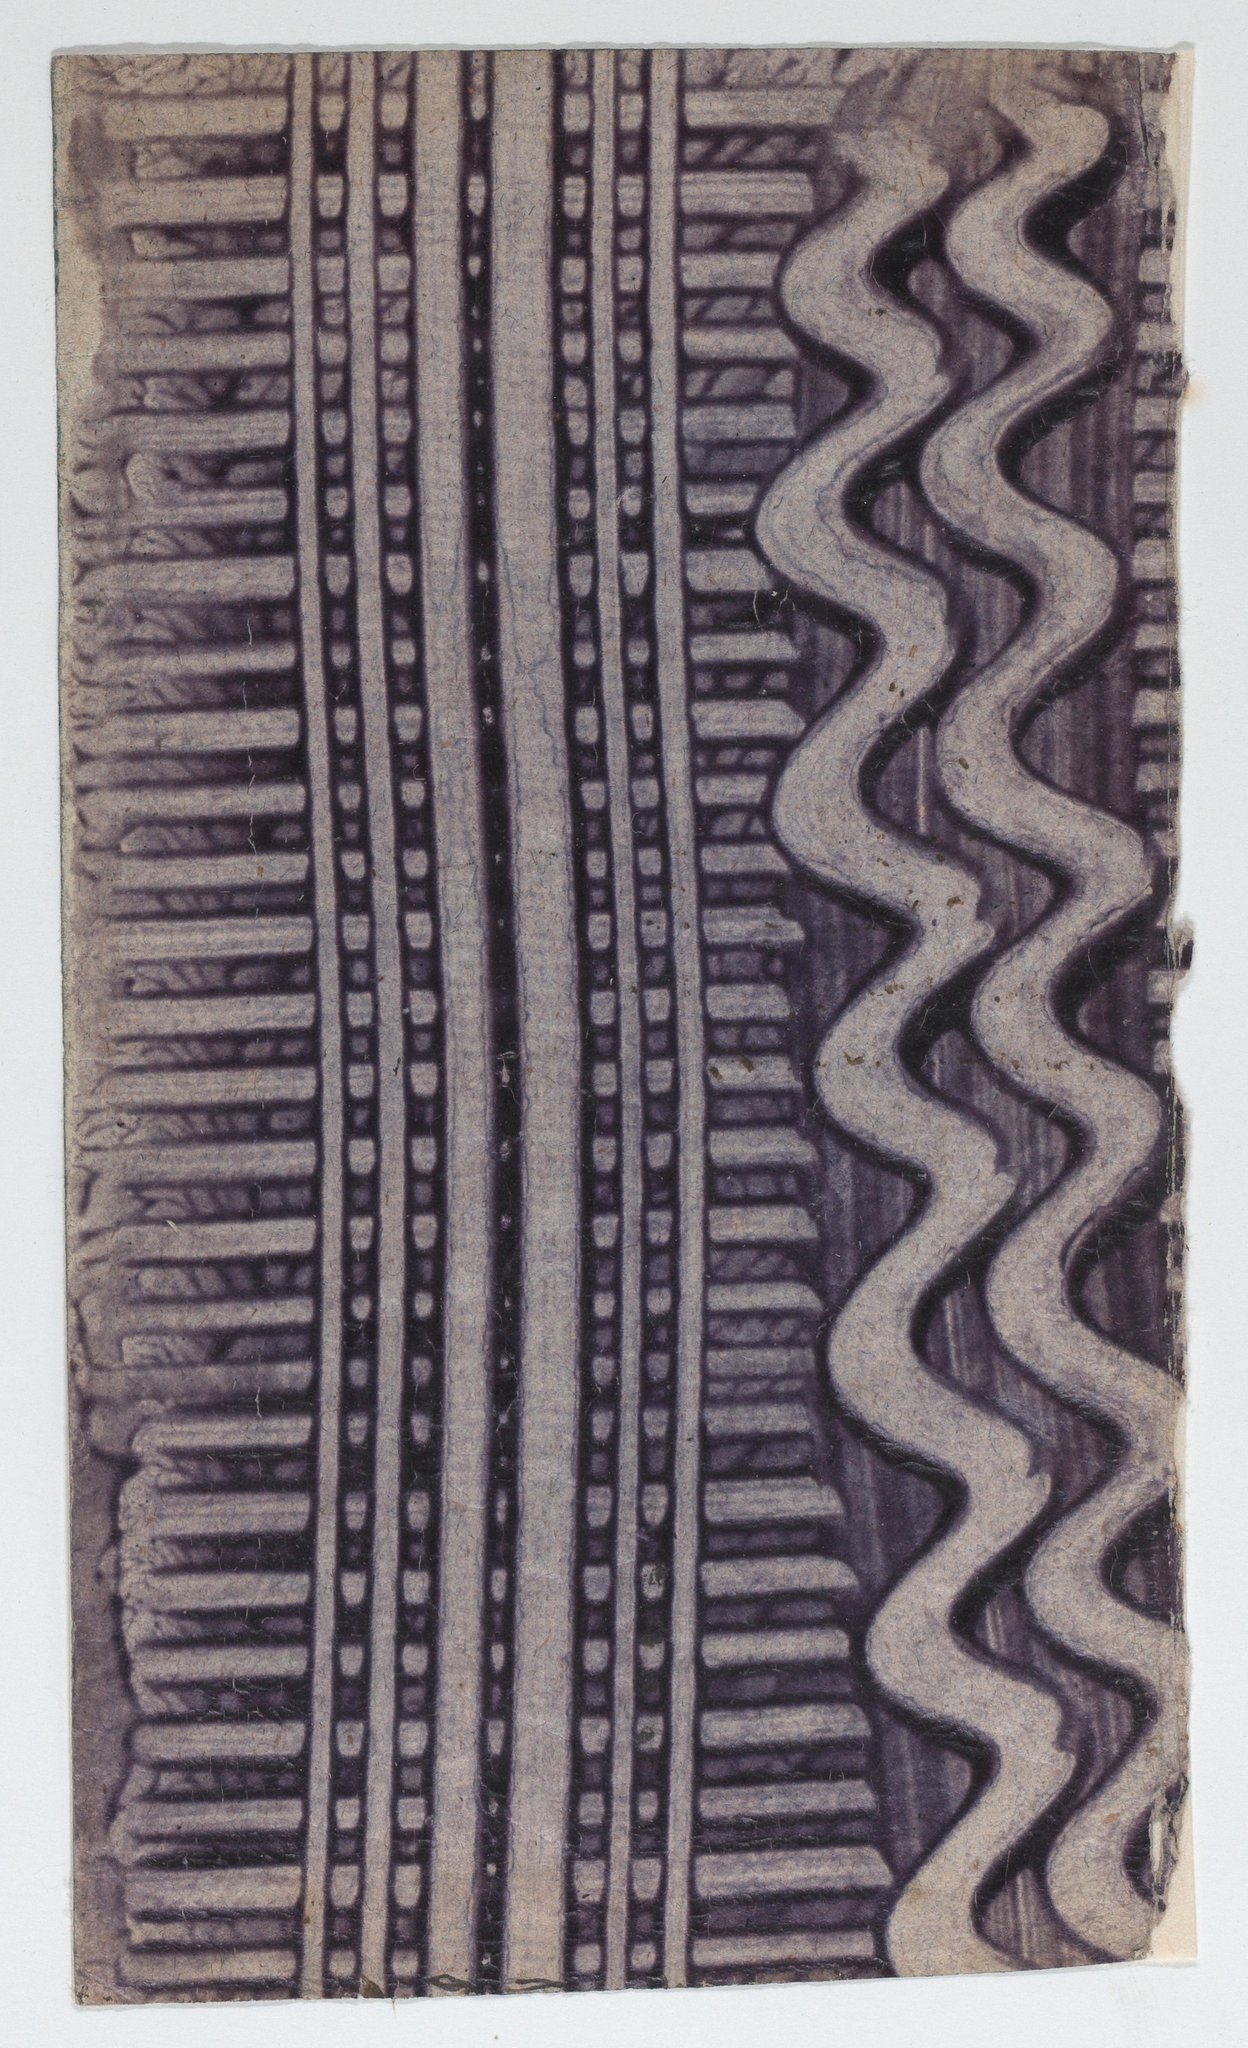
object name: print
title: Purple paste paper with curved line and crisscross design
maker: Anonymous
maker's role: artist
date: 1801-1900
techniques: relief print